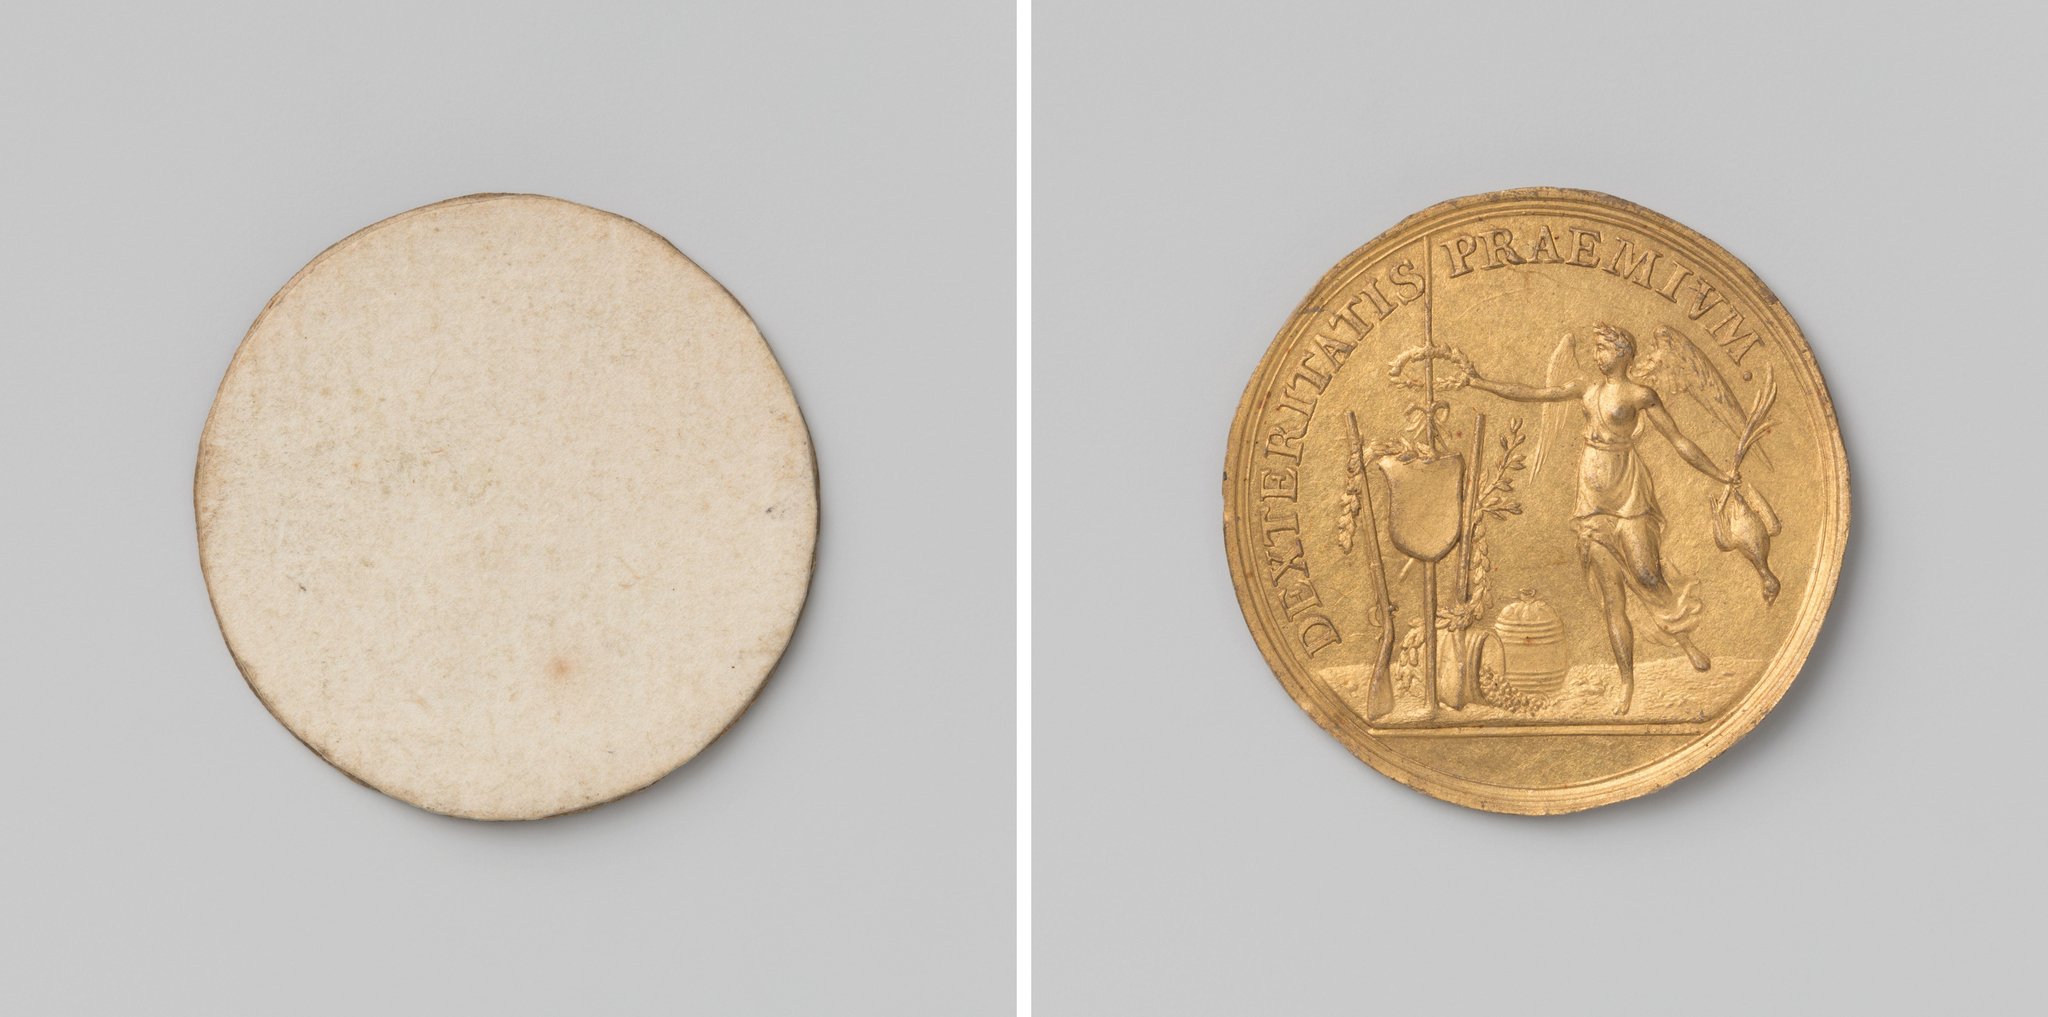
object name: koningspenning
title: Ridderlijke Confrerie van de Handbussche te Delft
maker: gerard van loon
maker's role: designer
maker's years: 1683-1758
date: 1718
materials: cardboard, paper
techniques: gilding, striking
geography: netherlands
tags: delft